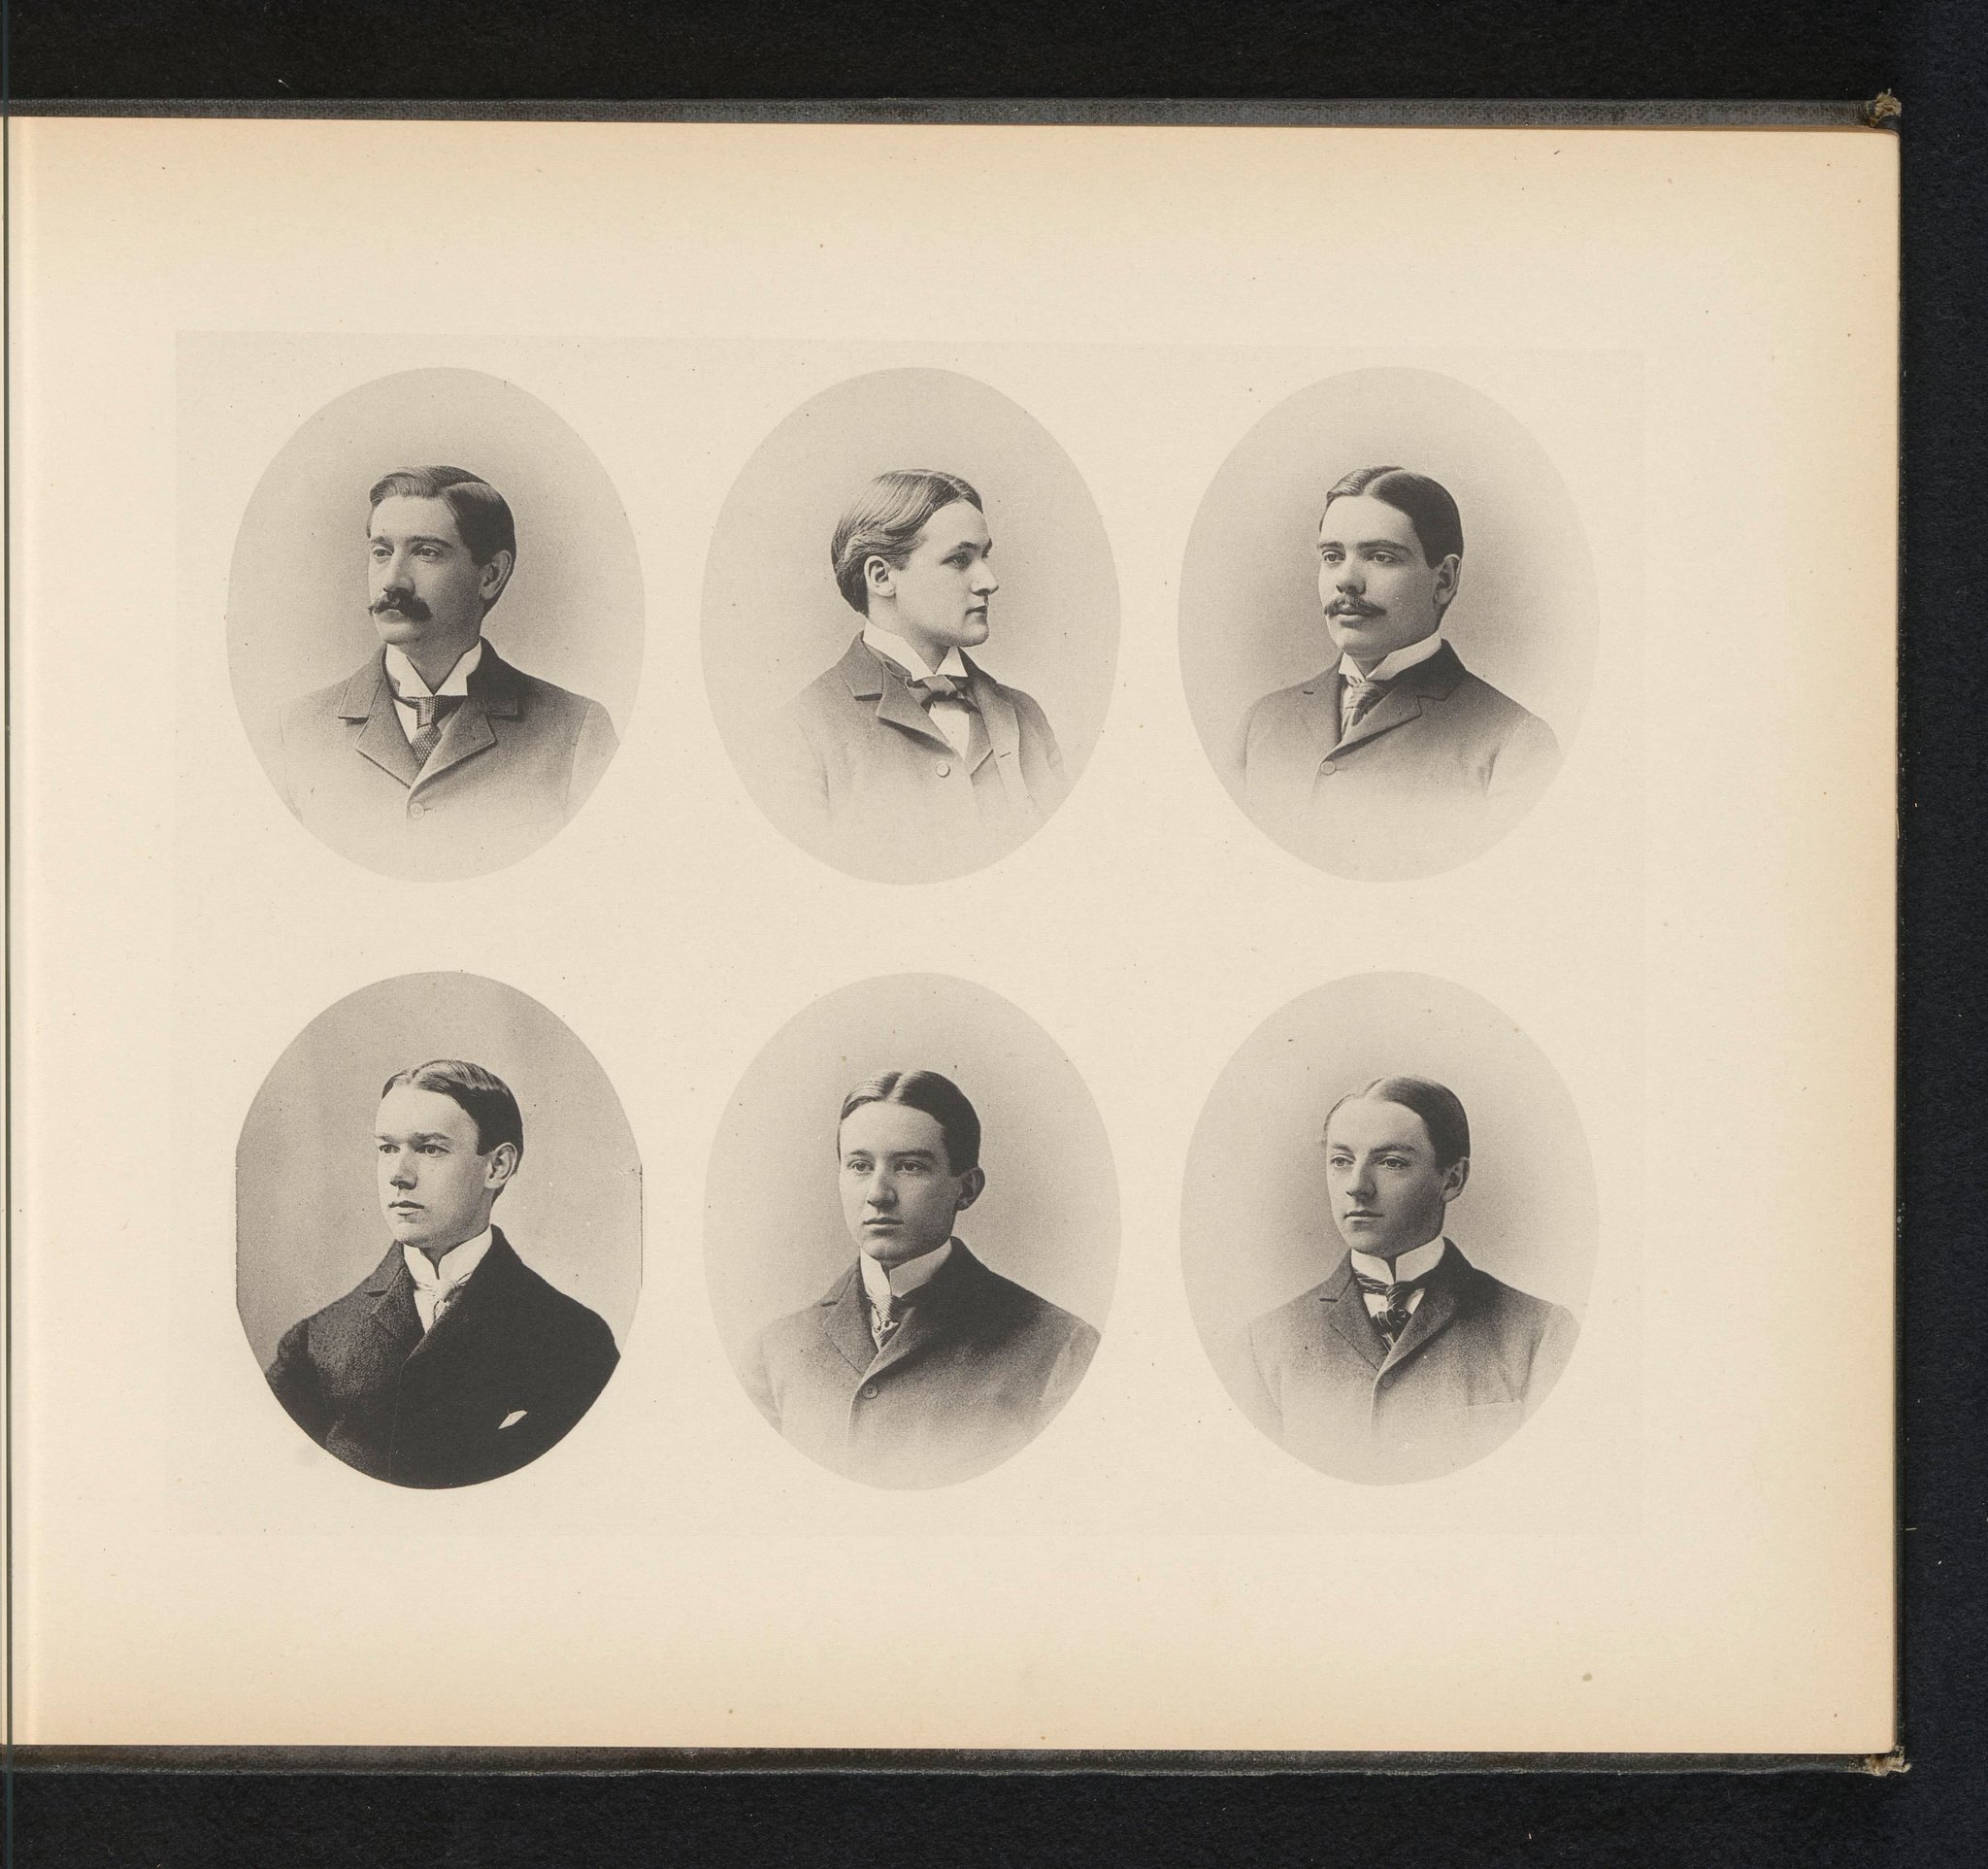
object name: page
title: Zes portretten van afgestudeerde studenten van Yale University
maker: Anonymous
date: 1895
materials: paper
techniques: photograph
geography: new york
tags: student